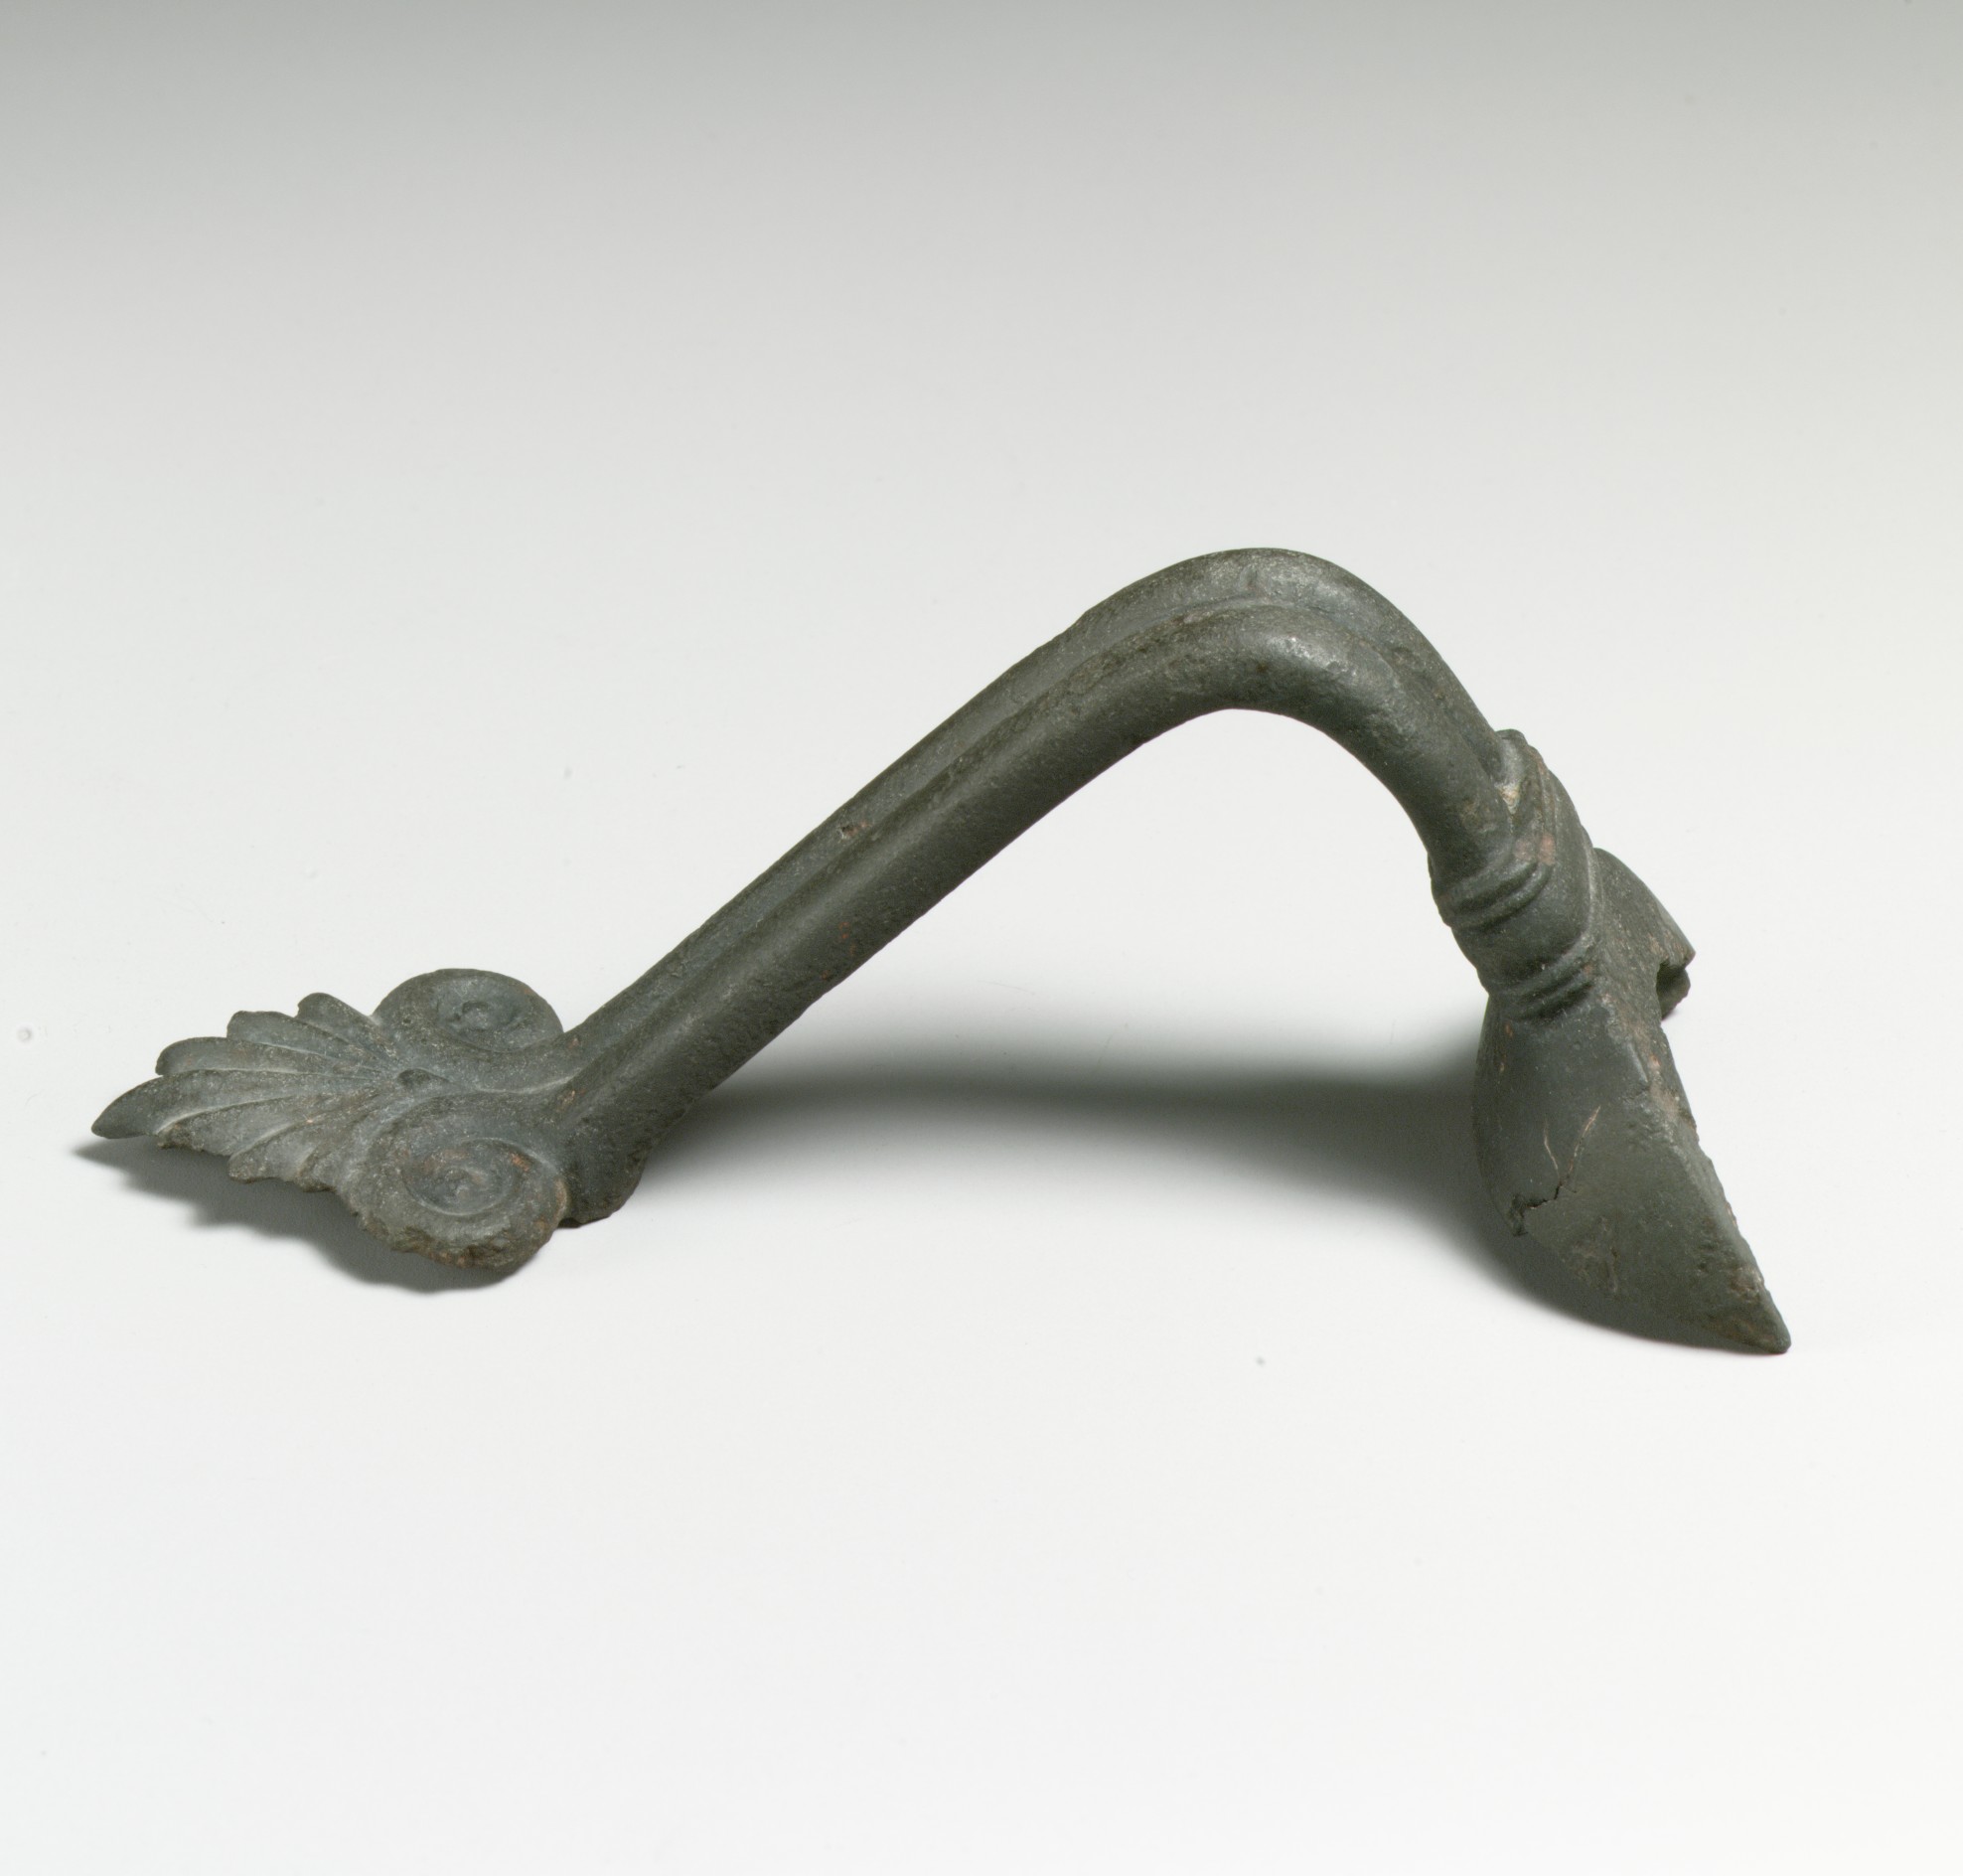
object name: handle of a jug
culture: cypriot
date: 600-401 BCE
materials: bronze